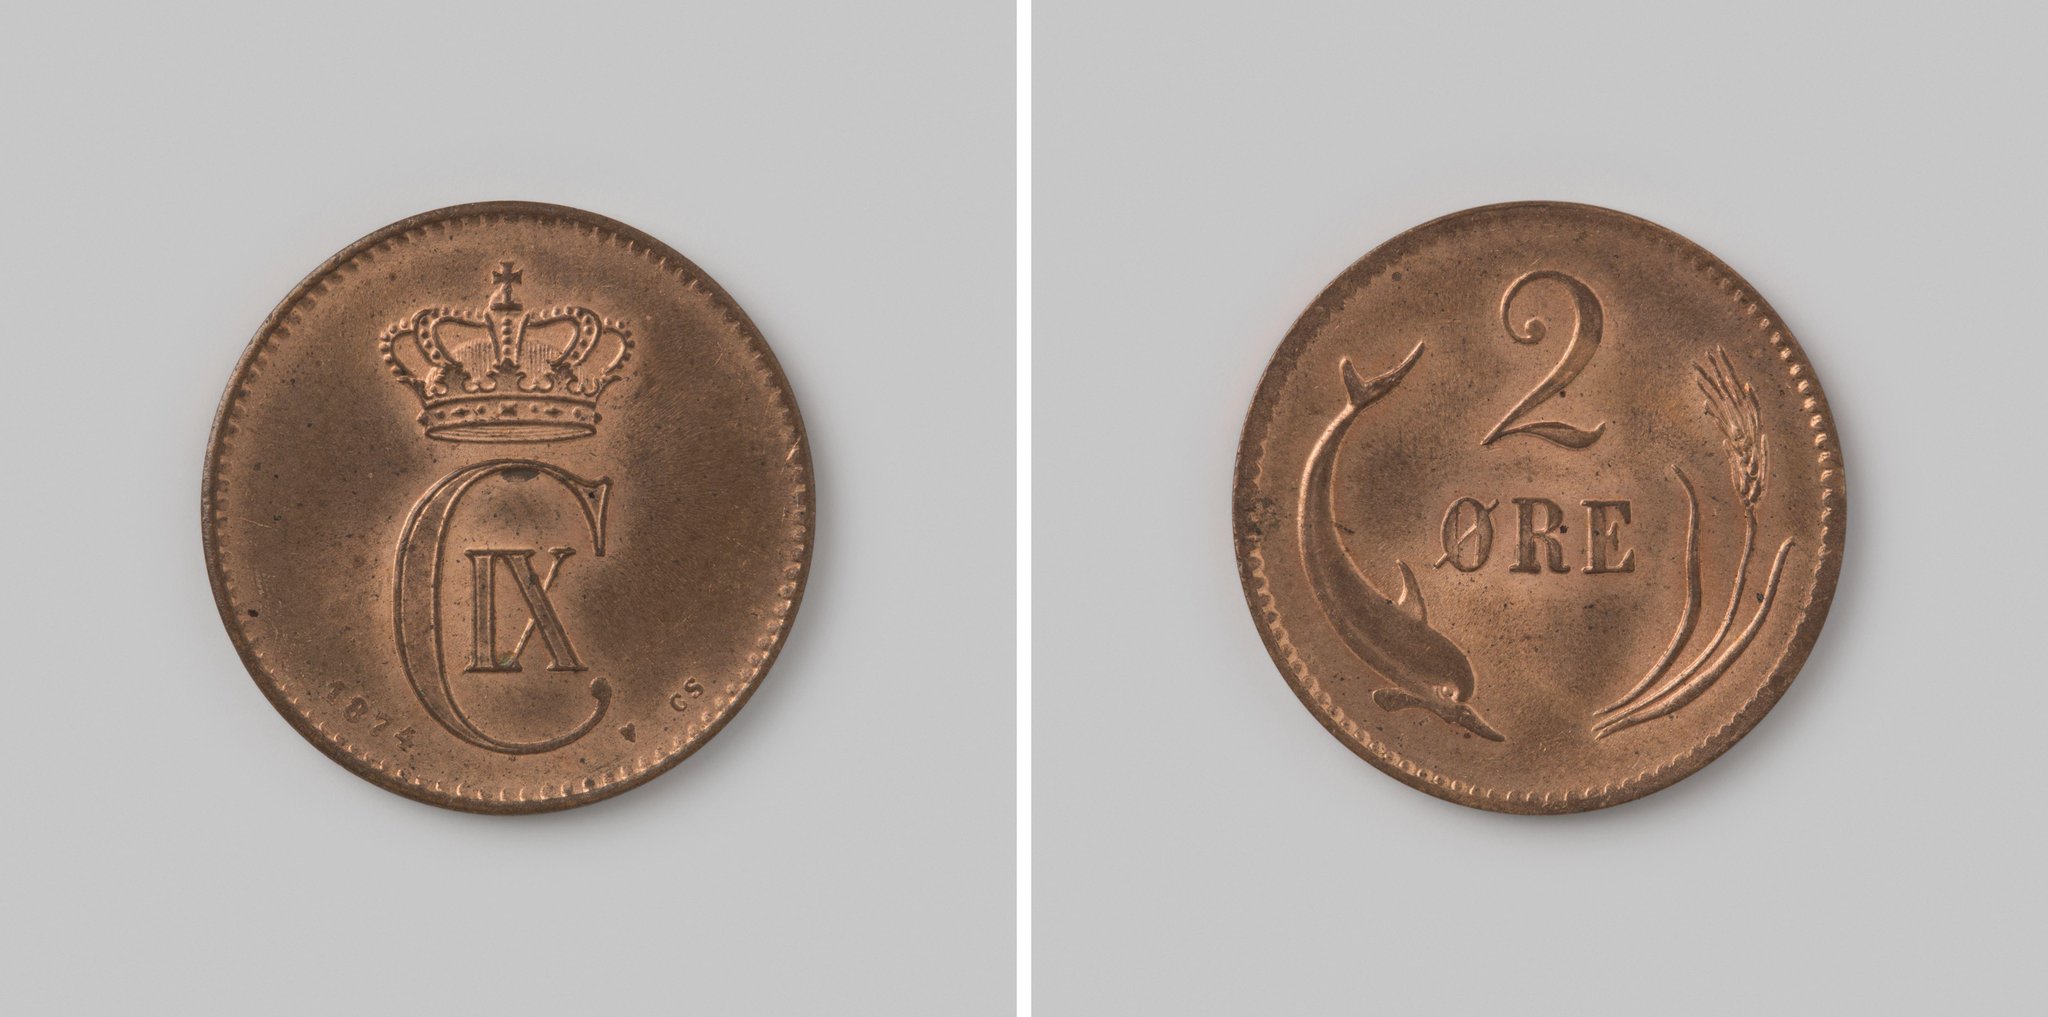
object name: twee øre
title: 2 øre uit Denemarken van Christiaan IX, 1874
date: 1874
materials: bronze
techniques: striking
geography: copenhagen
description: Bronzen munt. Voorzijde: gekroond monogram van de koning. Daaronder links jaartal. Keerzijde: tussen dolfijn en tak in twee regels waarde-aanduiding. Gladde rand.